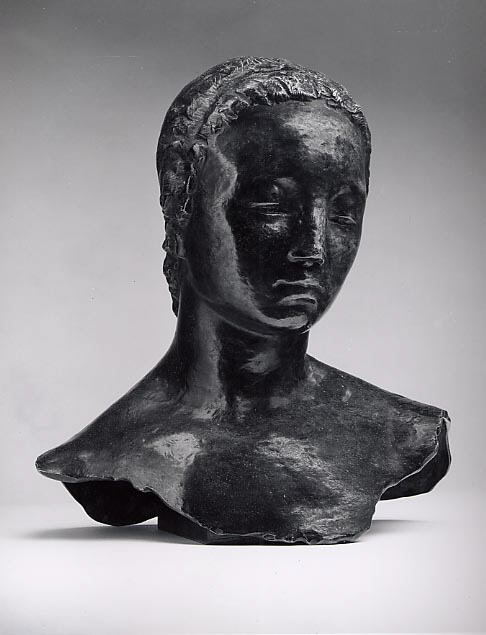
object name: sculpture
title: Head of a Woman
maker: wilhelm lehmbruck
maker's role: artist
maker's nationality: german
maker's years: 1881-1919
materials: bronze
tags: heads,women